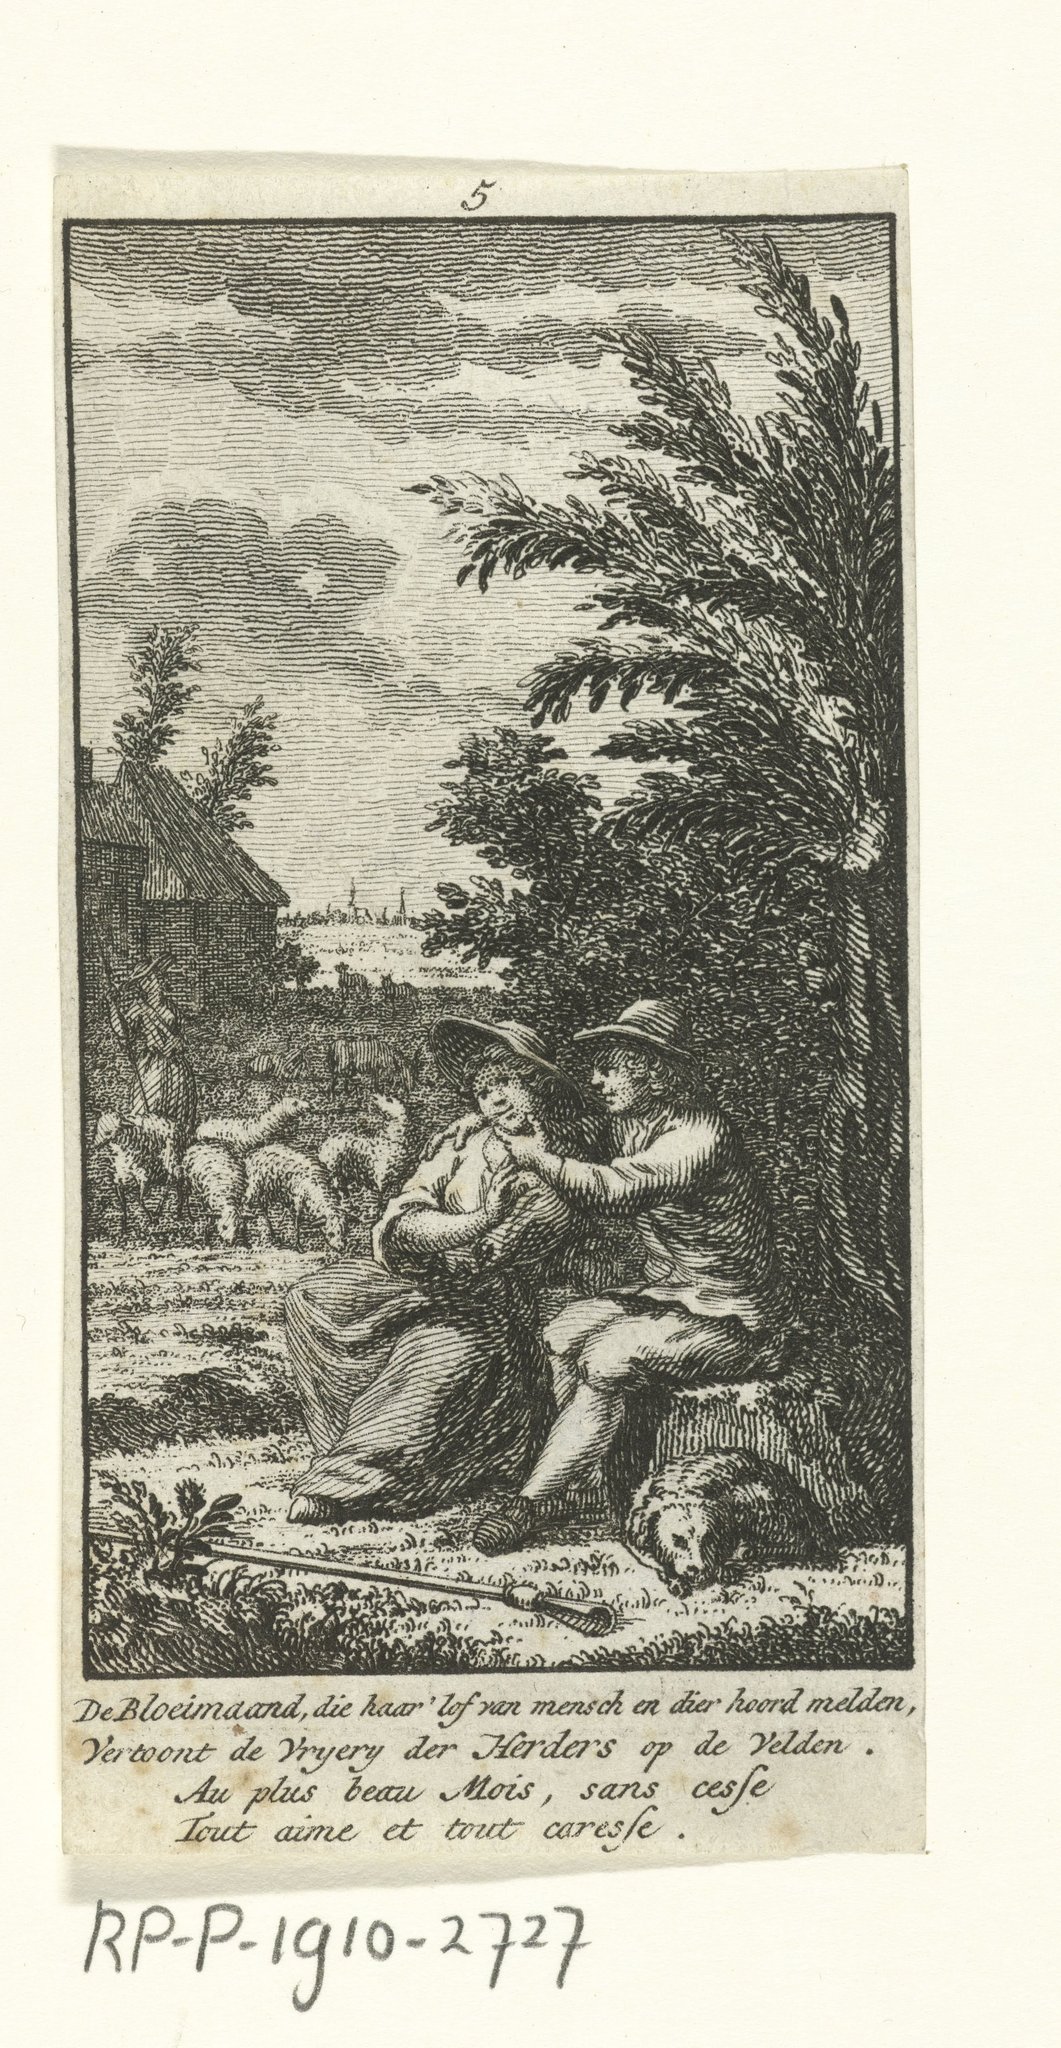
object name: print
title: Mei: minnend paar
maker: jan caspar philips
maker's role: draughtsman, print maker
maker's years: 1700-1775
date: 1736-1775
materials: paper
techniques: engraving, etching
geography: amsterdam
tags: may and its 'labours', cattle driving, cattle driver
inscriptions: collector's mark: Lugt 2228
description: De maand mei: een minnend herderpaar. Op de achtergrond een herder met zijn kudde schapen. In de marge een tweeregelig gedicht in het Nederlands en in het Frans.